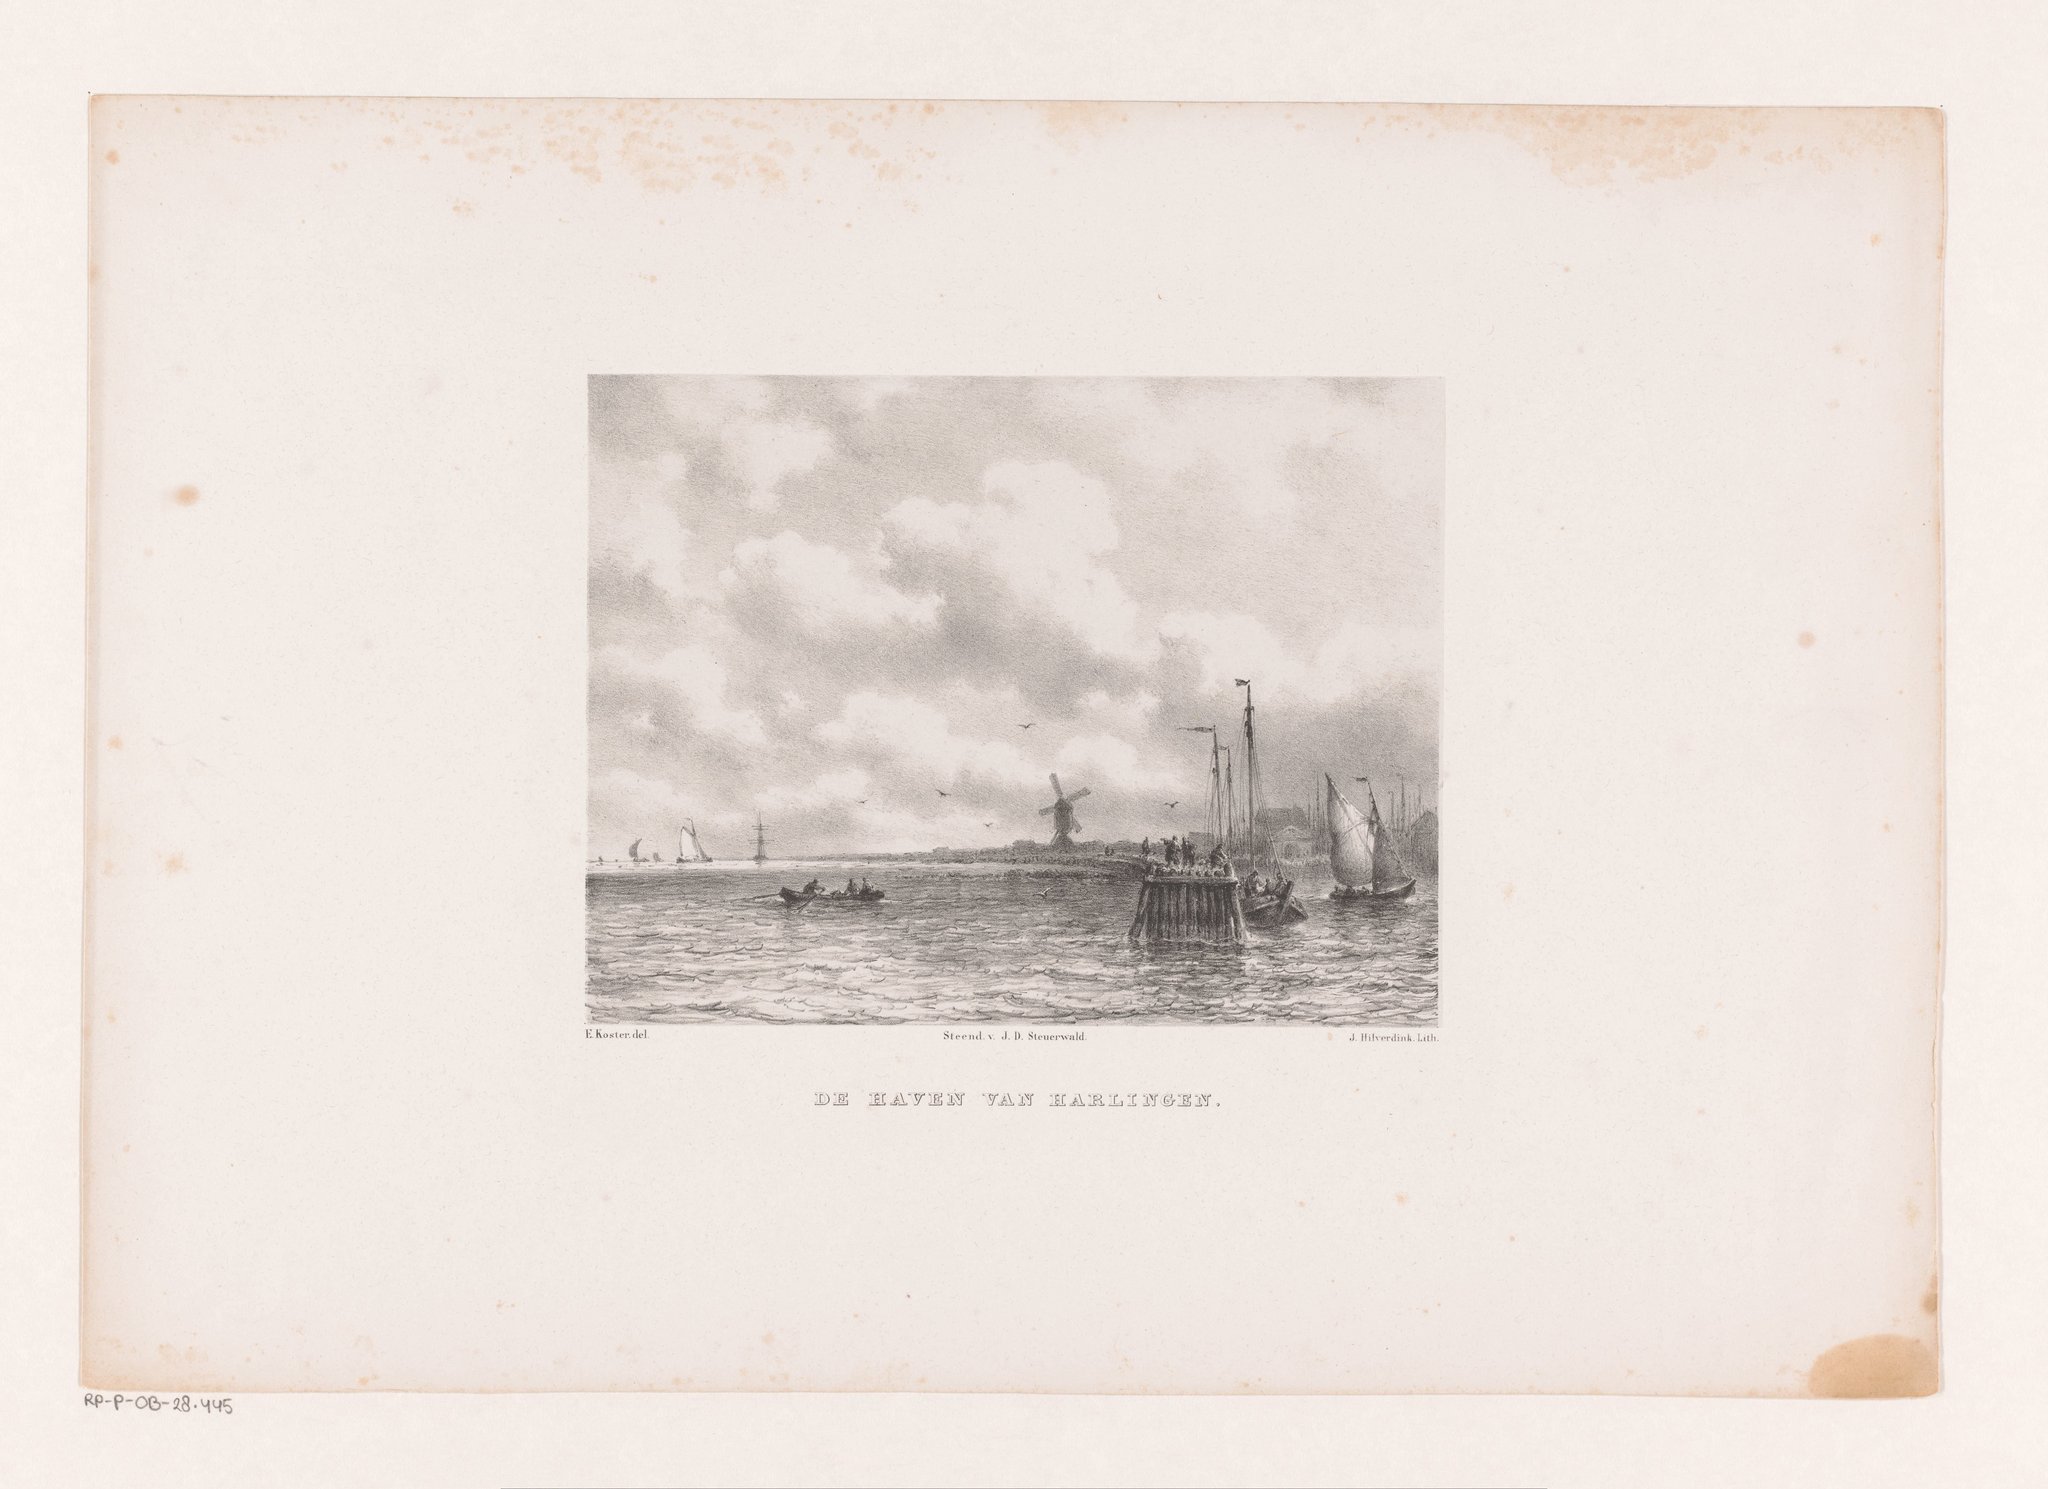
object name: print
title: Haven van Harlingen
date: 1858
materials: paper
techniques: lithograph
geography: amsterdam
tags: harbour, pier, quay, wharf, windmill in landscape (+ city(-scape) with figures, staffage), harlingen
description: Deze prent komt uit: Koster, E. 'E. Koster's schetsboek: Nederlandsche Stads- en Havengezichten, uitgegeven onder medewerking van de maatschappij Arti et Amicitiae, Amsterdam, F. Buffa en Zn., e.a.' Amsterdam 1858.